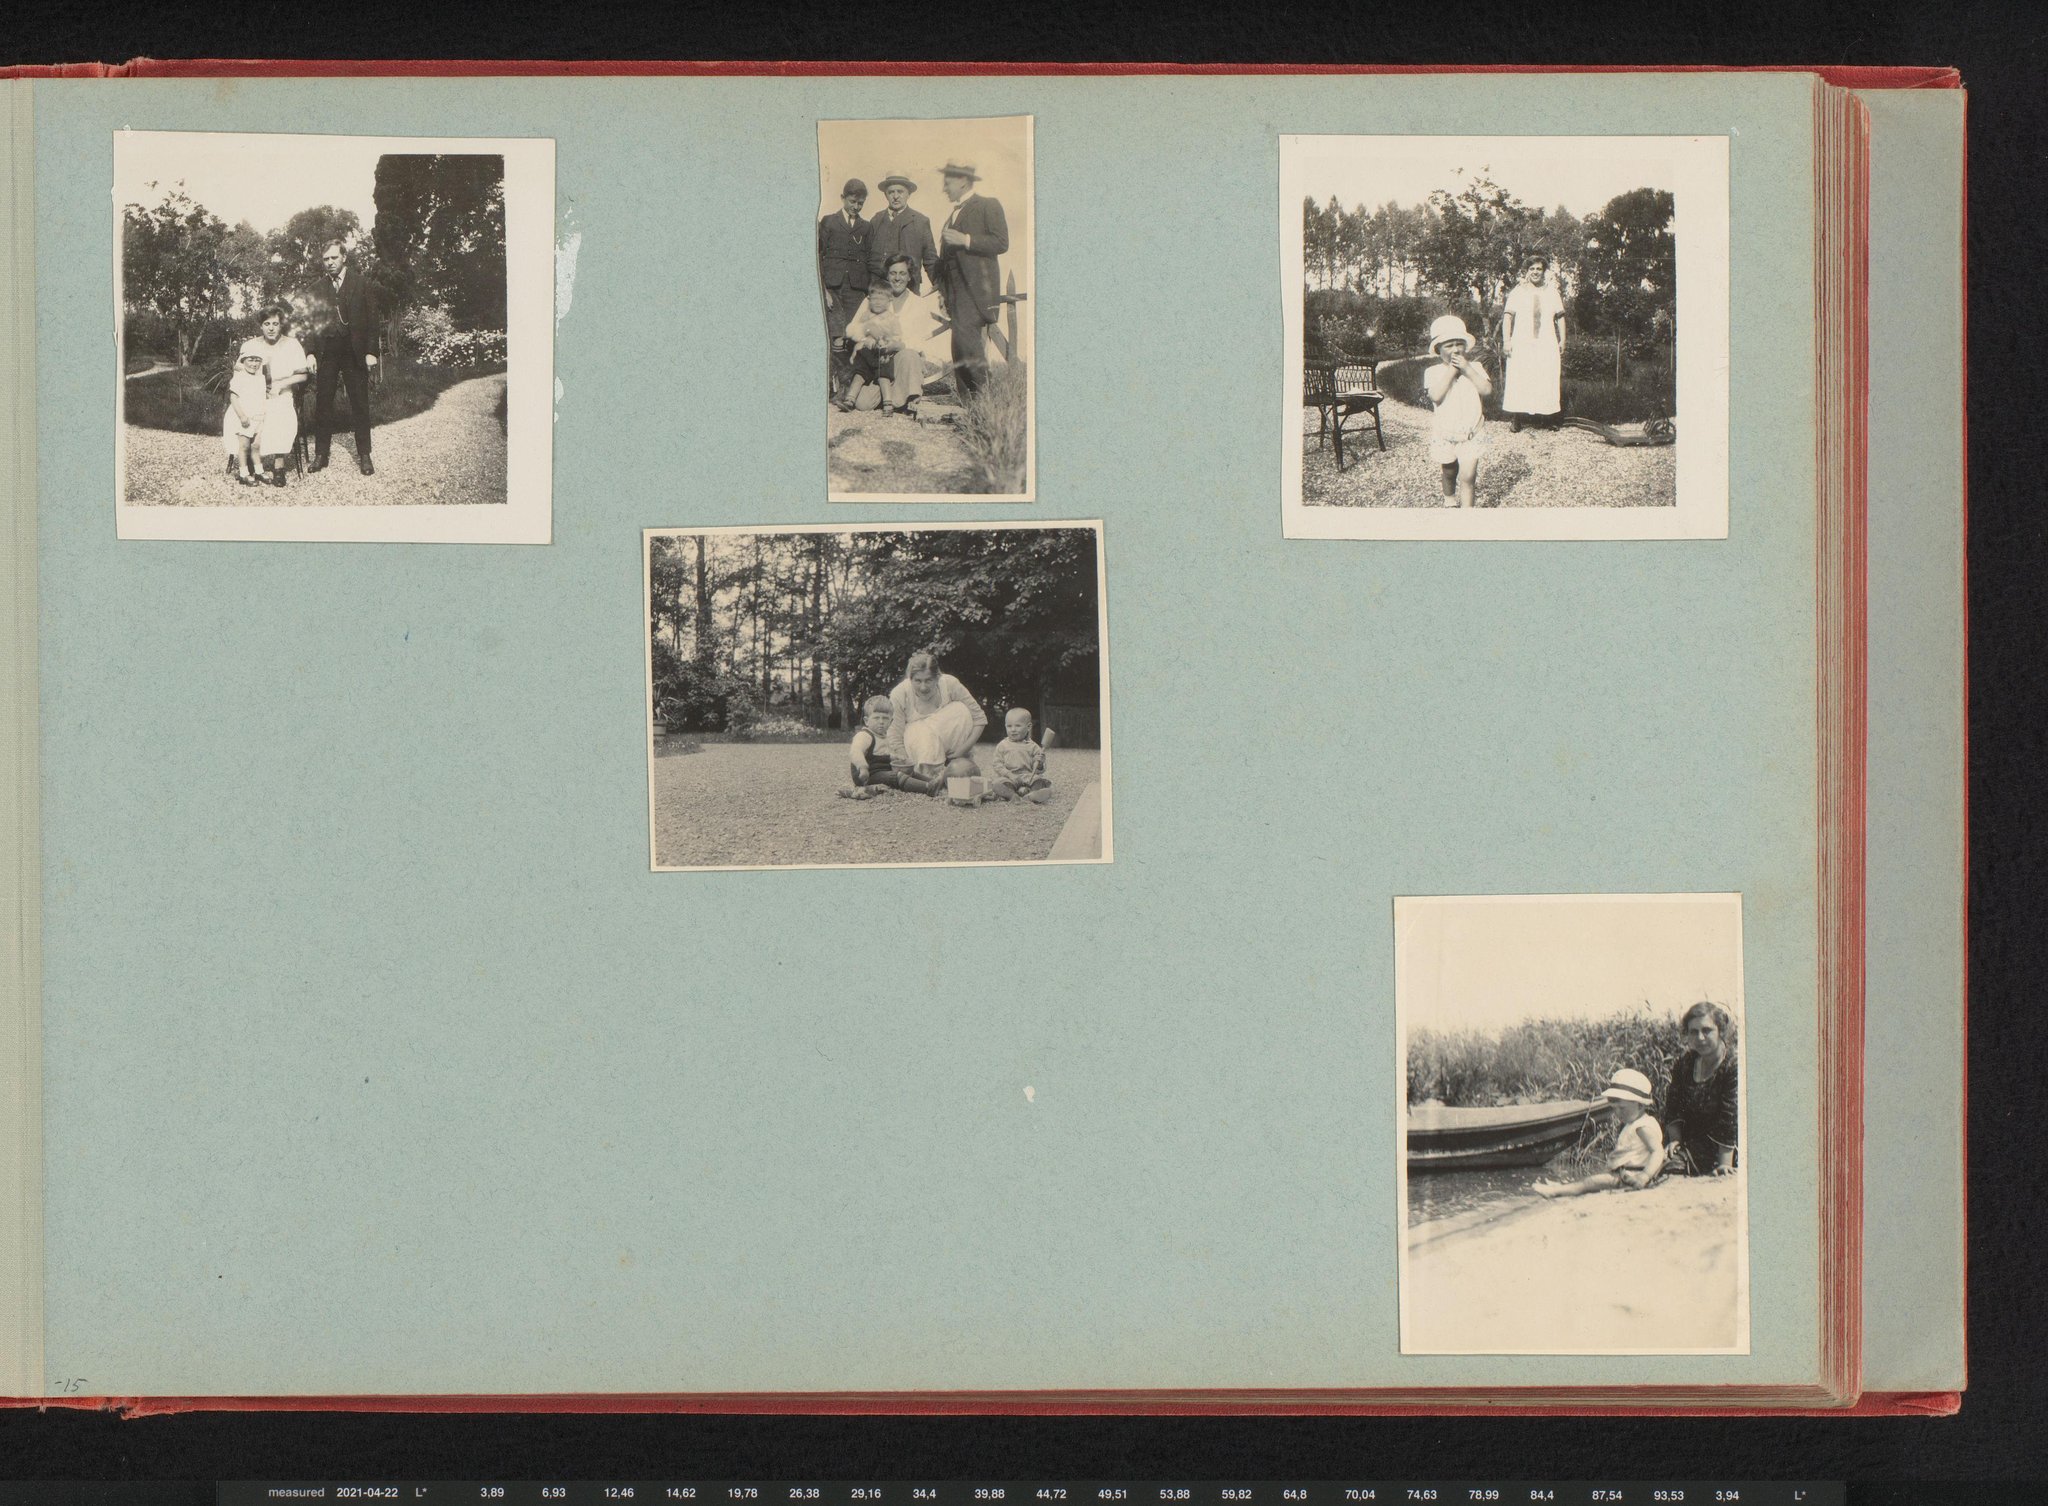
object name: photograph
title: Verschillende portretten van leden van de familie Graswinckel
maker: Anonymous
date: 1915-1925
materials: paper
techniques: gelatin silver print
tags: anonymous historical person portrayed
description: Deze foto's zijn onderdeel van een album.